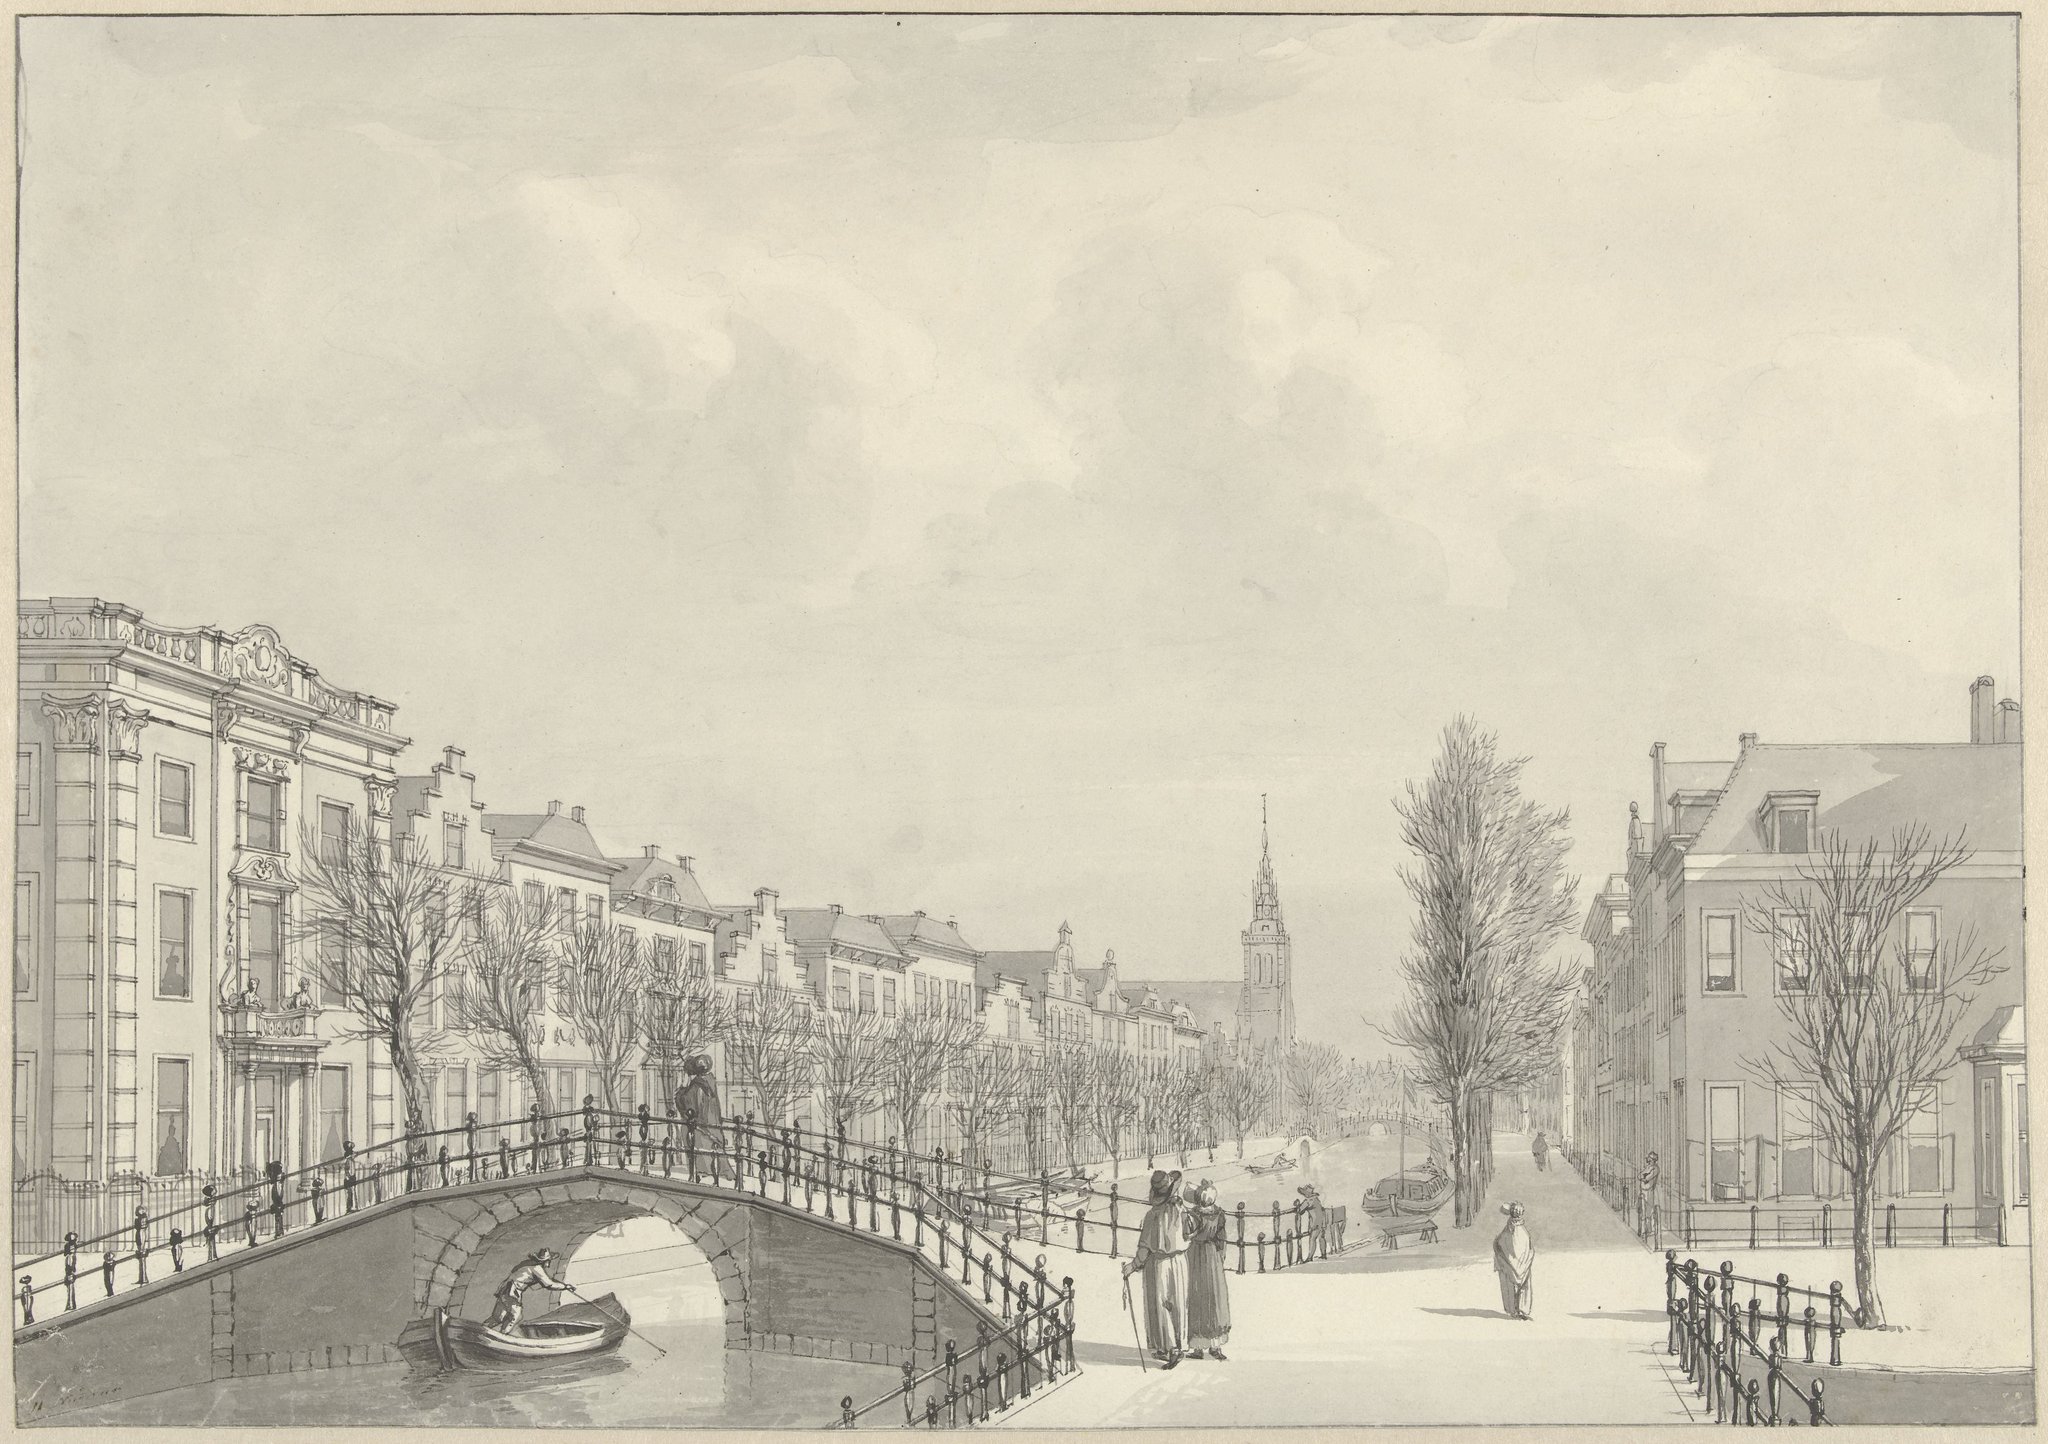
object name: design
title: Gezicht op het Rapenburg te Leiden van de Nieuwsteegbrug, 1807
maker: hermanus numan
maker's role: draughtsman, painter, print maker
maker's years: 1744-1820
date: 1807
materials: paper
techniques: brush, pen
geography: leiden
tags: street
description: Gezicht op het Rapenburg te Leiden, in welstand vóór de buskruitramp van 12 januari 1807. Links op de voorgrond de Nieuwsteegbrug met daarachter het Steenschuur. Links op de hoek van het Steenschuur het huis van schepen J.W. van Noort. Op de achtergrond de Saaihal (de latere Sint-Lodewijkskerk).